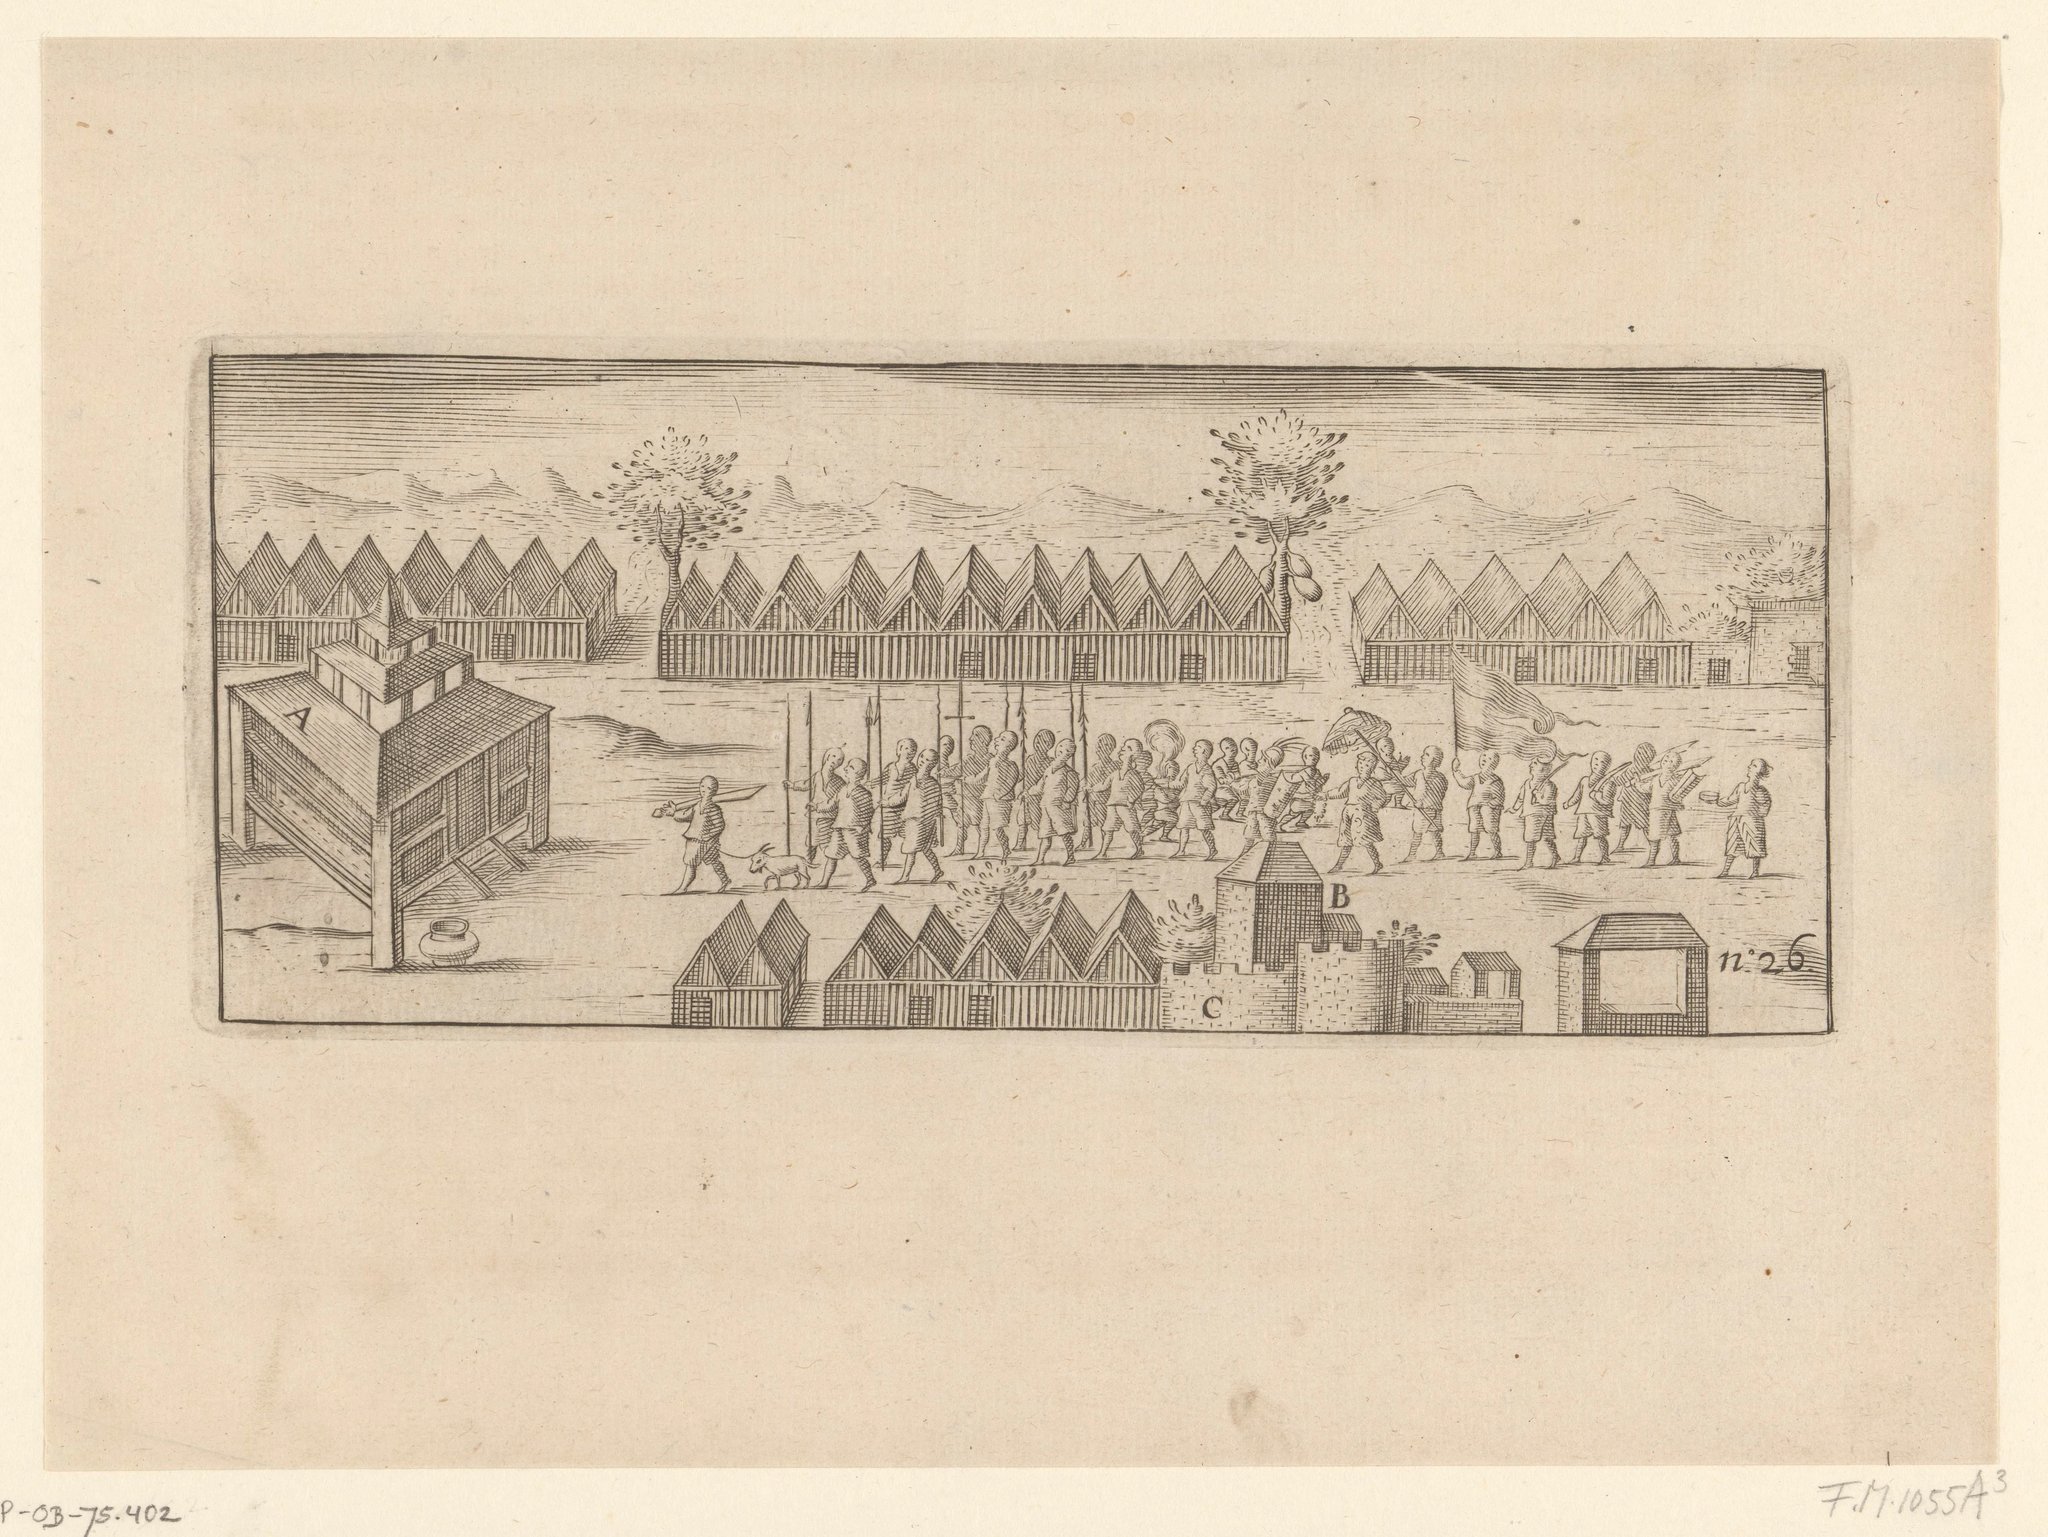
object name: print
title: De koning van Ternate bezoekt de moskee, 1599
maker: Anonymous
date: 1600-1601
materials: paper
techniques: engraving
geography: northern netherlands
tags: mayor, landscapes in tropical and sub-tropical regions, temple, shrine ~ islam, mohammedanism, exploration, expedition, voyage of discovery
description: Gebruikt als illustratie eerst in: Journael ofte Dagh-register, inhoudende een waerachtigh verhael ... vande reyse, ghedaen door de acht schepen van Amsterdamme, onde 'tbeleydt van Iacob Cornelisz. Neck. als Admirael, ende VVybrandt van VVarvvijck, als Vice-admirael, van Amsterdam gheseylt inden jare 1598, Cornelis Claes, Amsterdam [1600], plaat No. 16. In deze staat gebruikt in: Oost-Indische ende West-Indische voyagien, Michiel Colijn, Amsterdam 1619 en later in: Waerachtigh verhael van de Schipvaerd op Oost-Indien ghedaen by de acht Schepen in den jare 1598 van Amsterdam uyt-ghezeylt, onder 't beleyd van den Admirael Jacob Cornelissoon van Neck, ende Vice-Admirael Wybrand van Warwijck. Opgenomen in: I. Commelin, Begin ende voortgangh, van de Vereenighde Nederlantsche Geoctroyeerde Oost-Indische Compagnie, J. Janssonius, Amsterdam 1646. Genummerd: 26.